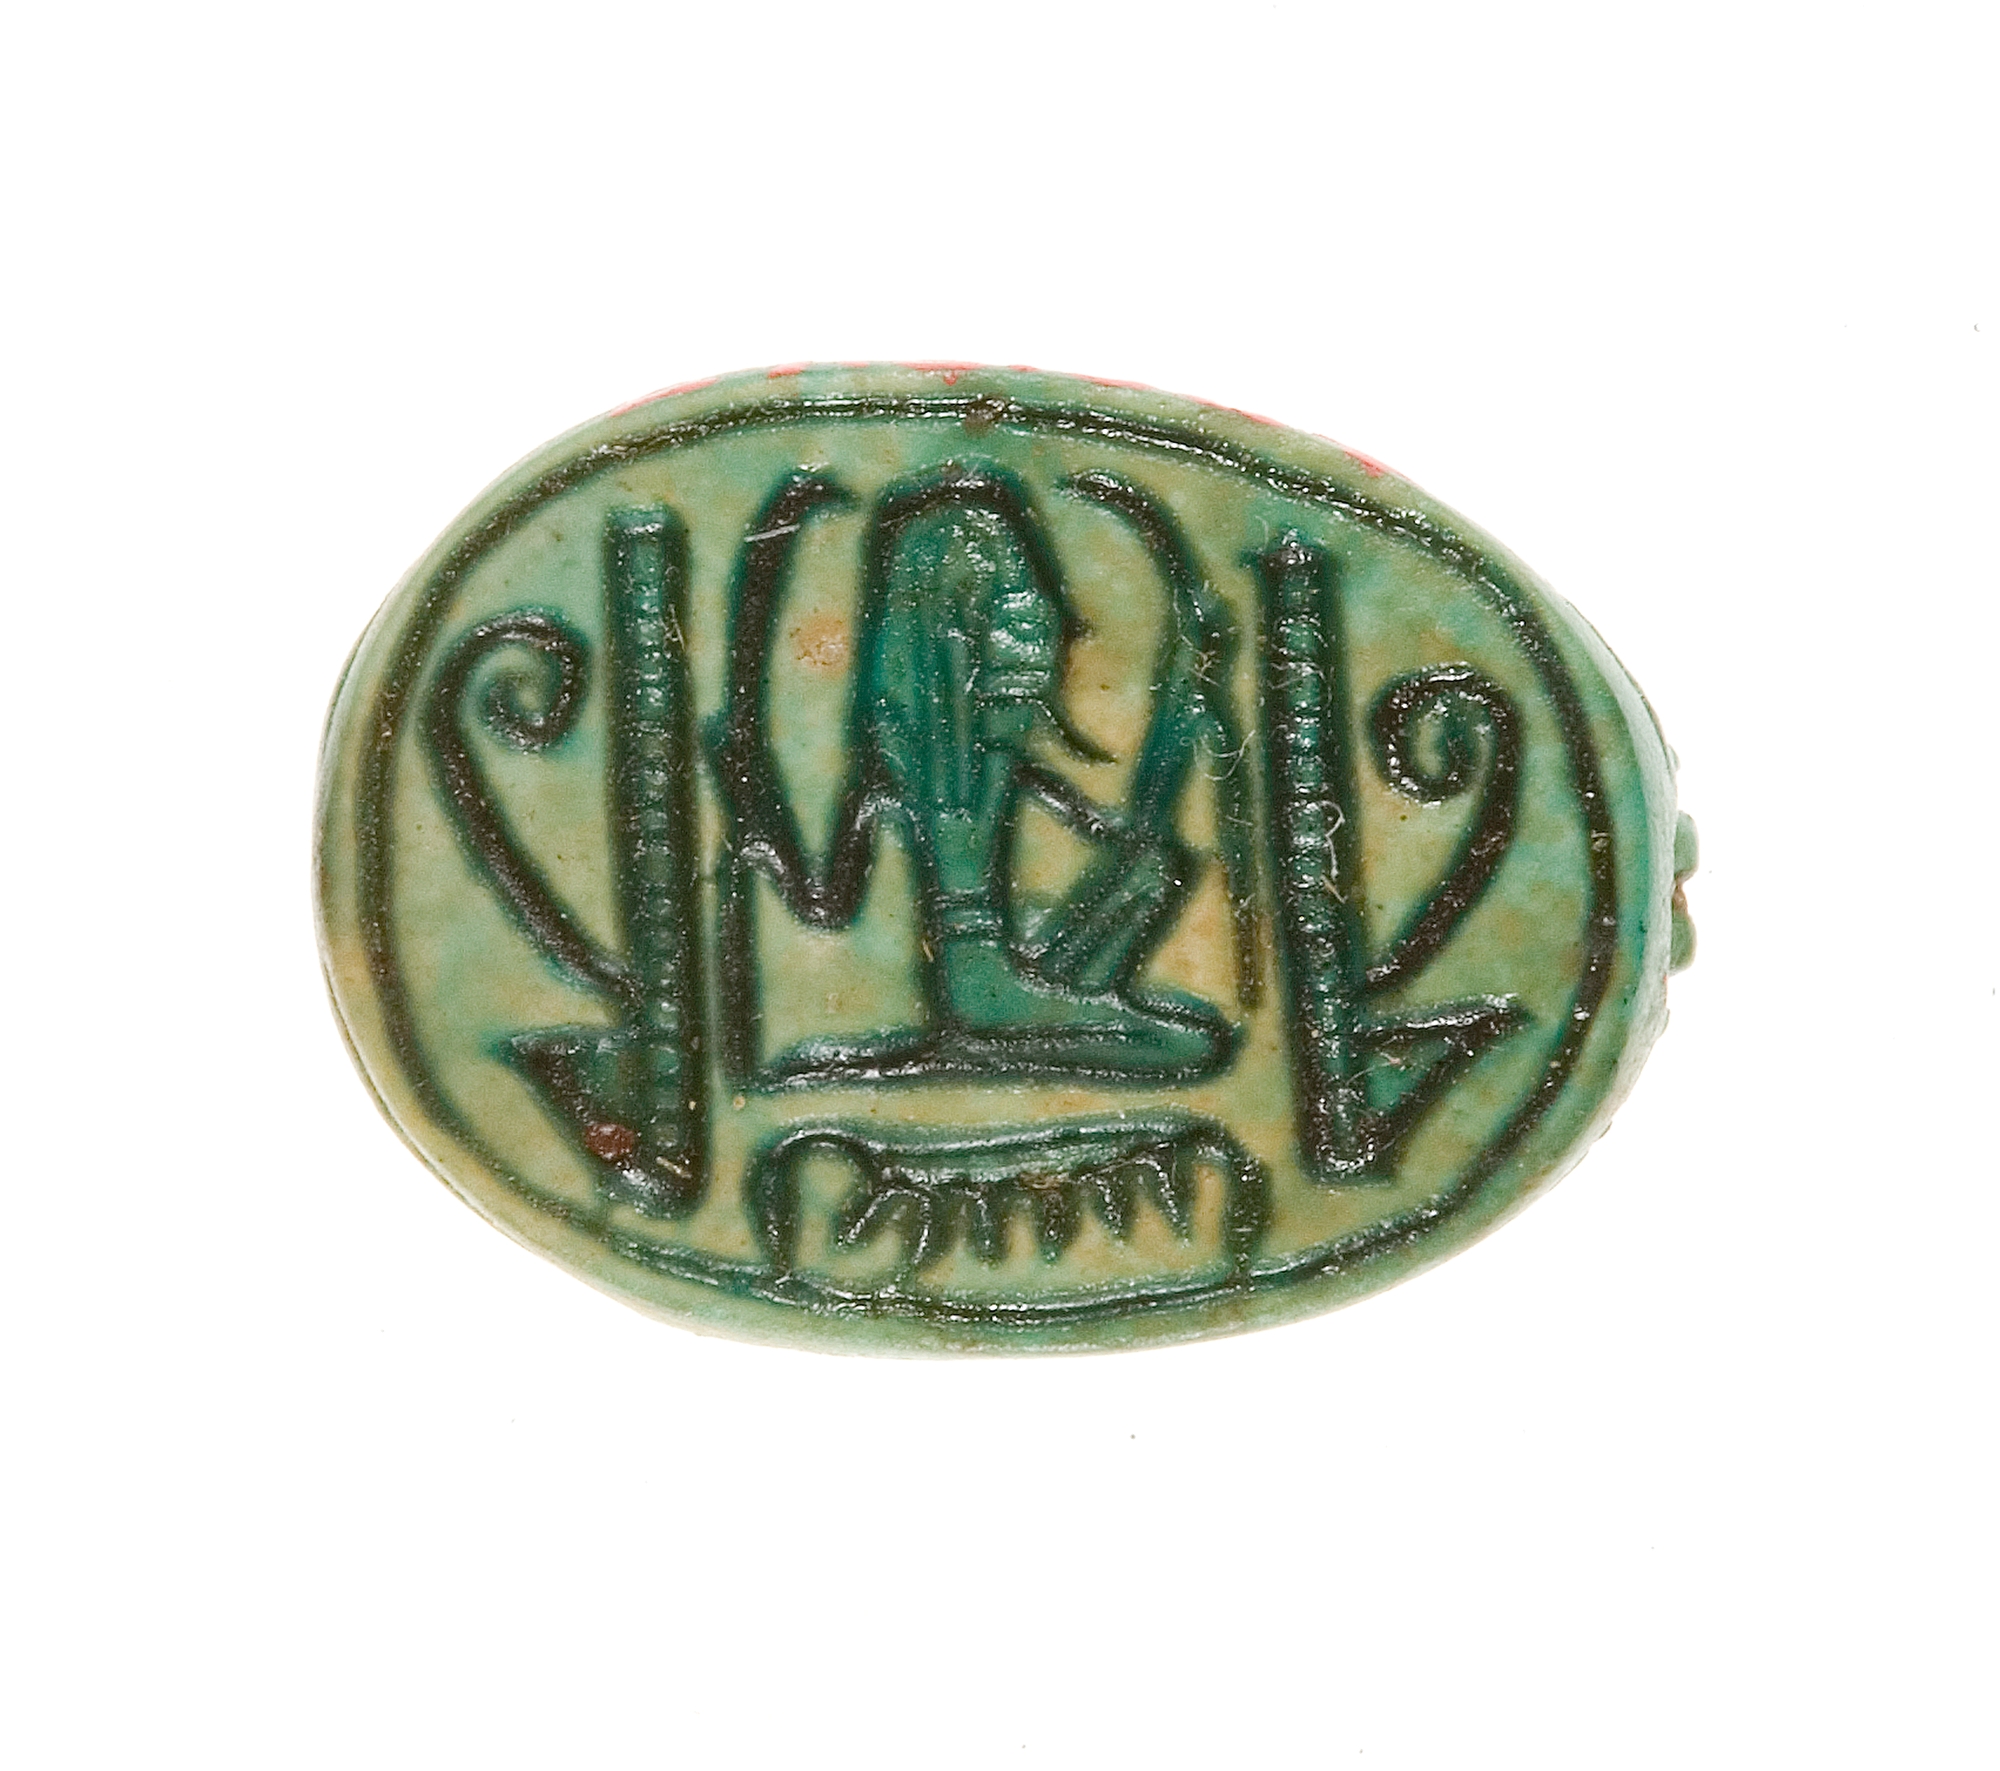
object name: scarab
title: Scarab Inscribed with a Hieroglyphic Motif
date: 1479-1458 BCE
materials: stone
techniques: glazing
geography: egypt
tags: hieroglyphs,scarabs